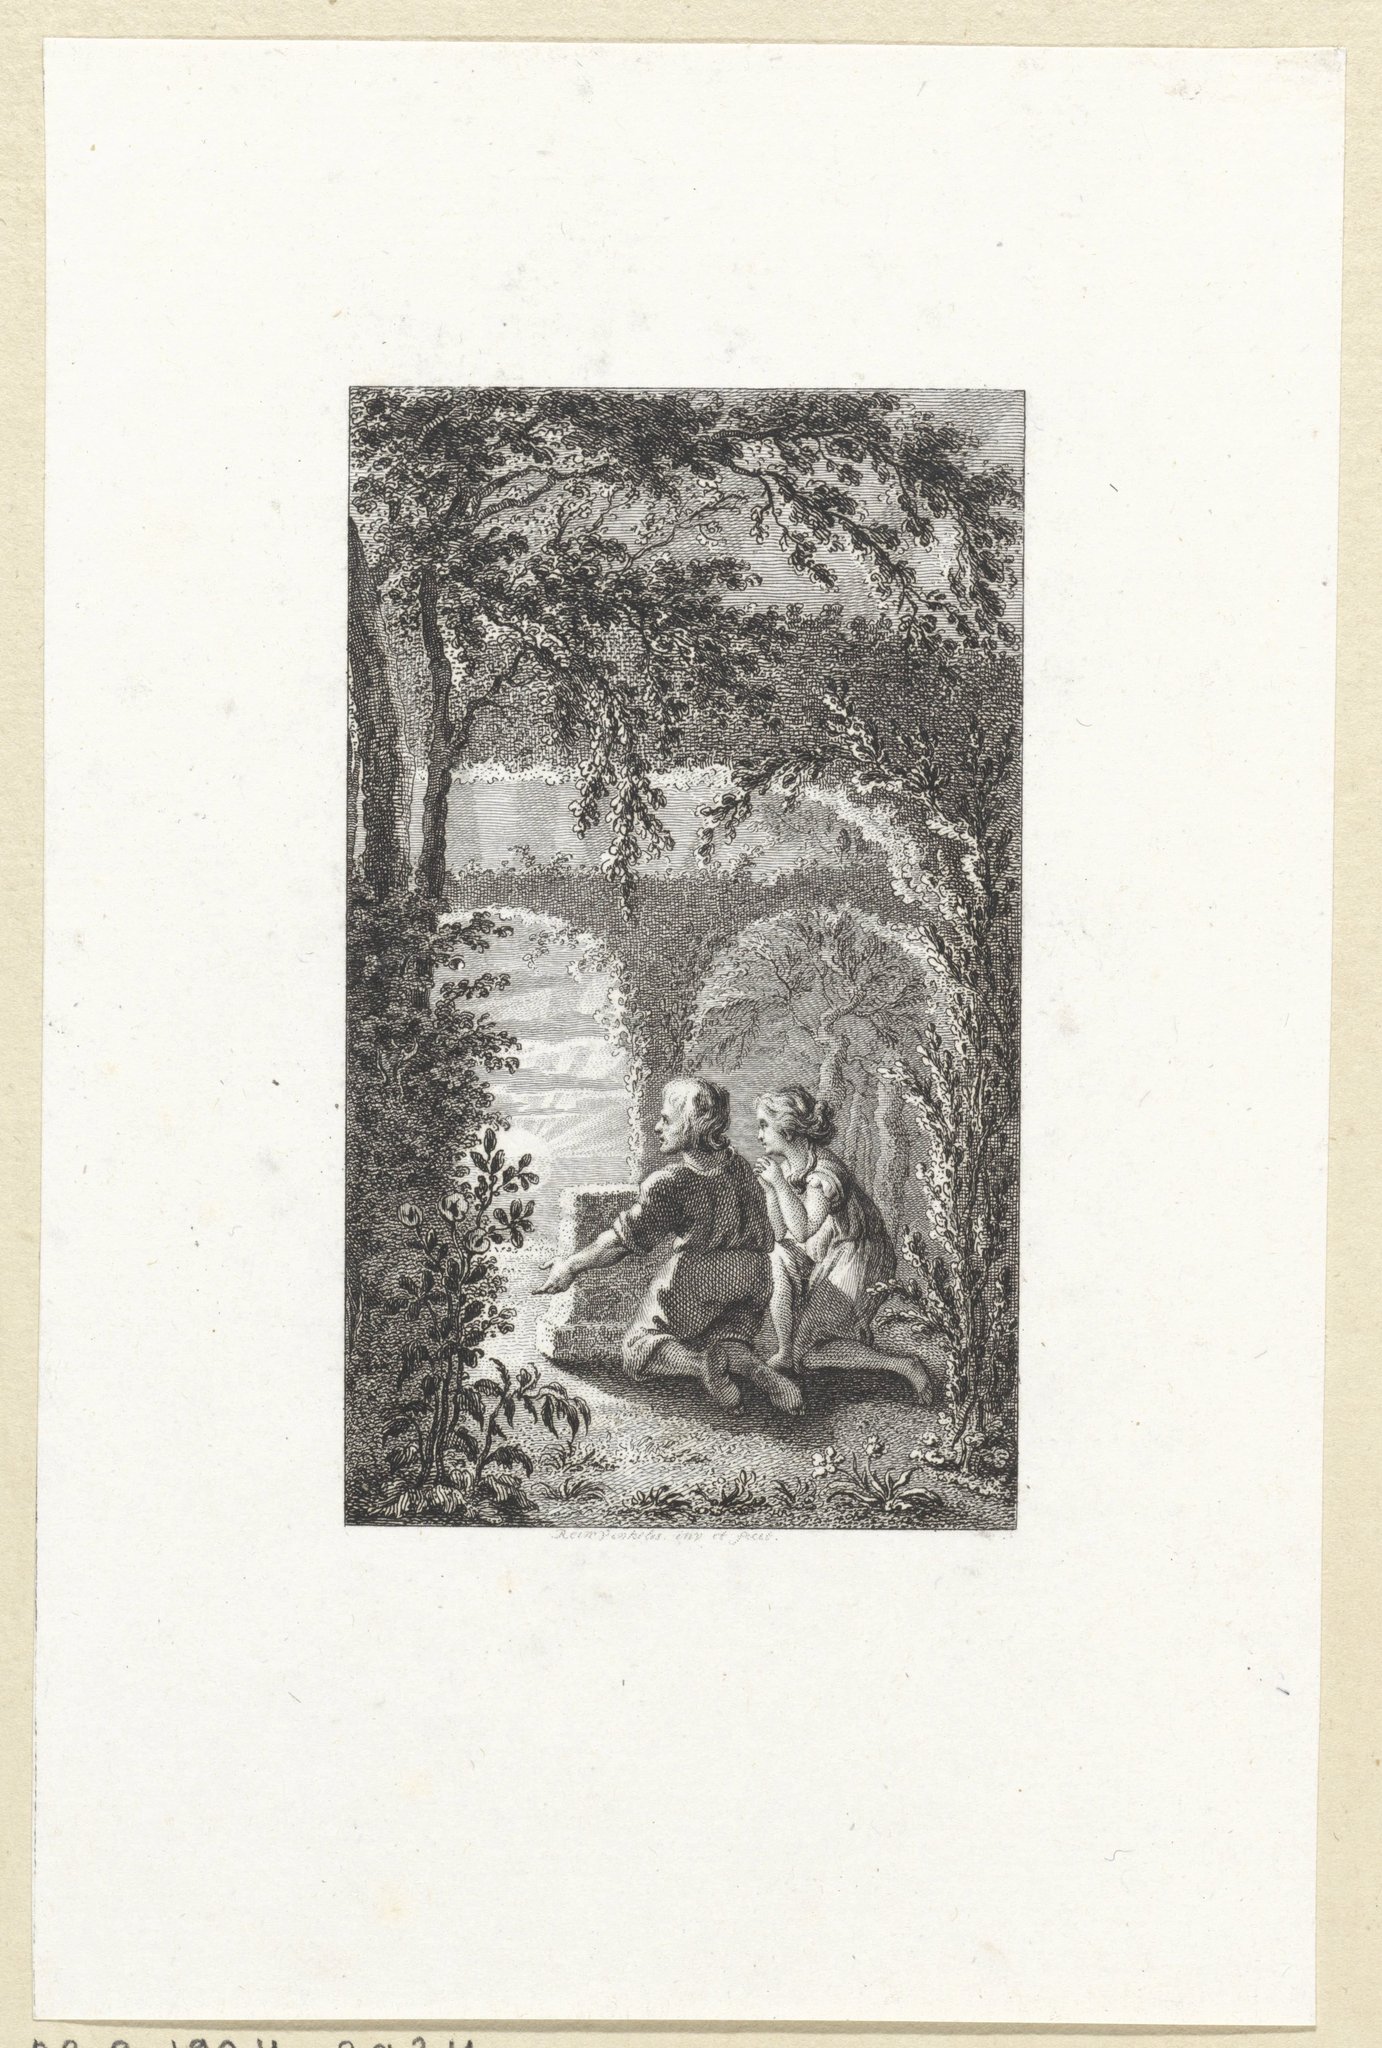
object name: print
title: Paulus en Virginia kijken naar de zon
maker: reinier vinkeles (i)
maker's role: draughtsman, print maker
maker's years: 1741-1816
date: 1751-1816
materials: paper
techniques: engraving, etching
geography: amsterdam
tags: garden, sunrise, sunset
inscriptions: collector's mark: Lugt 2228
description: In een tuin kijken Paulus en Virginia van achter een struik naar de zon. Illustratie bij het verhaal 'Paul et Virginie', over de liefde tussen een blank meisje en een blanke jongen die begin 18e eeuw samen opgroeien in een Franse kolonie.